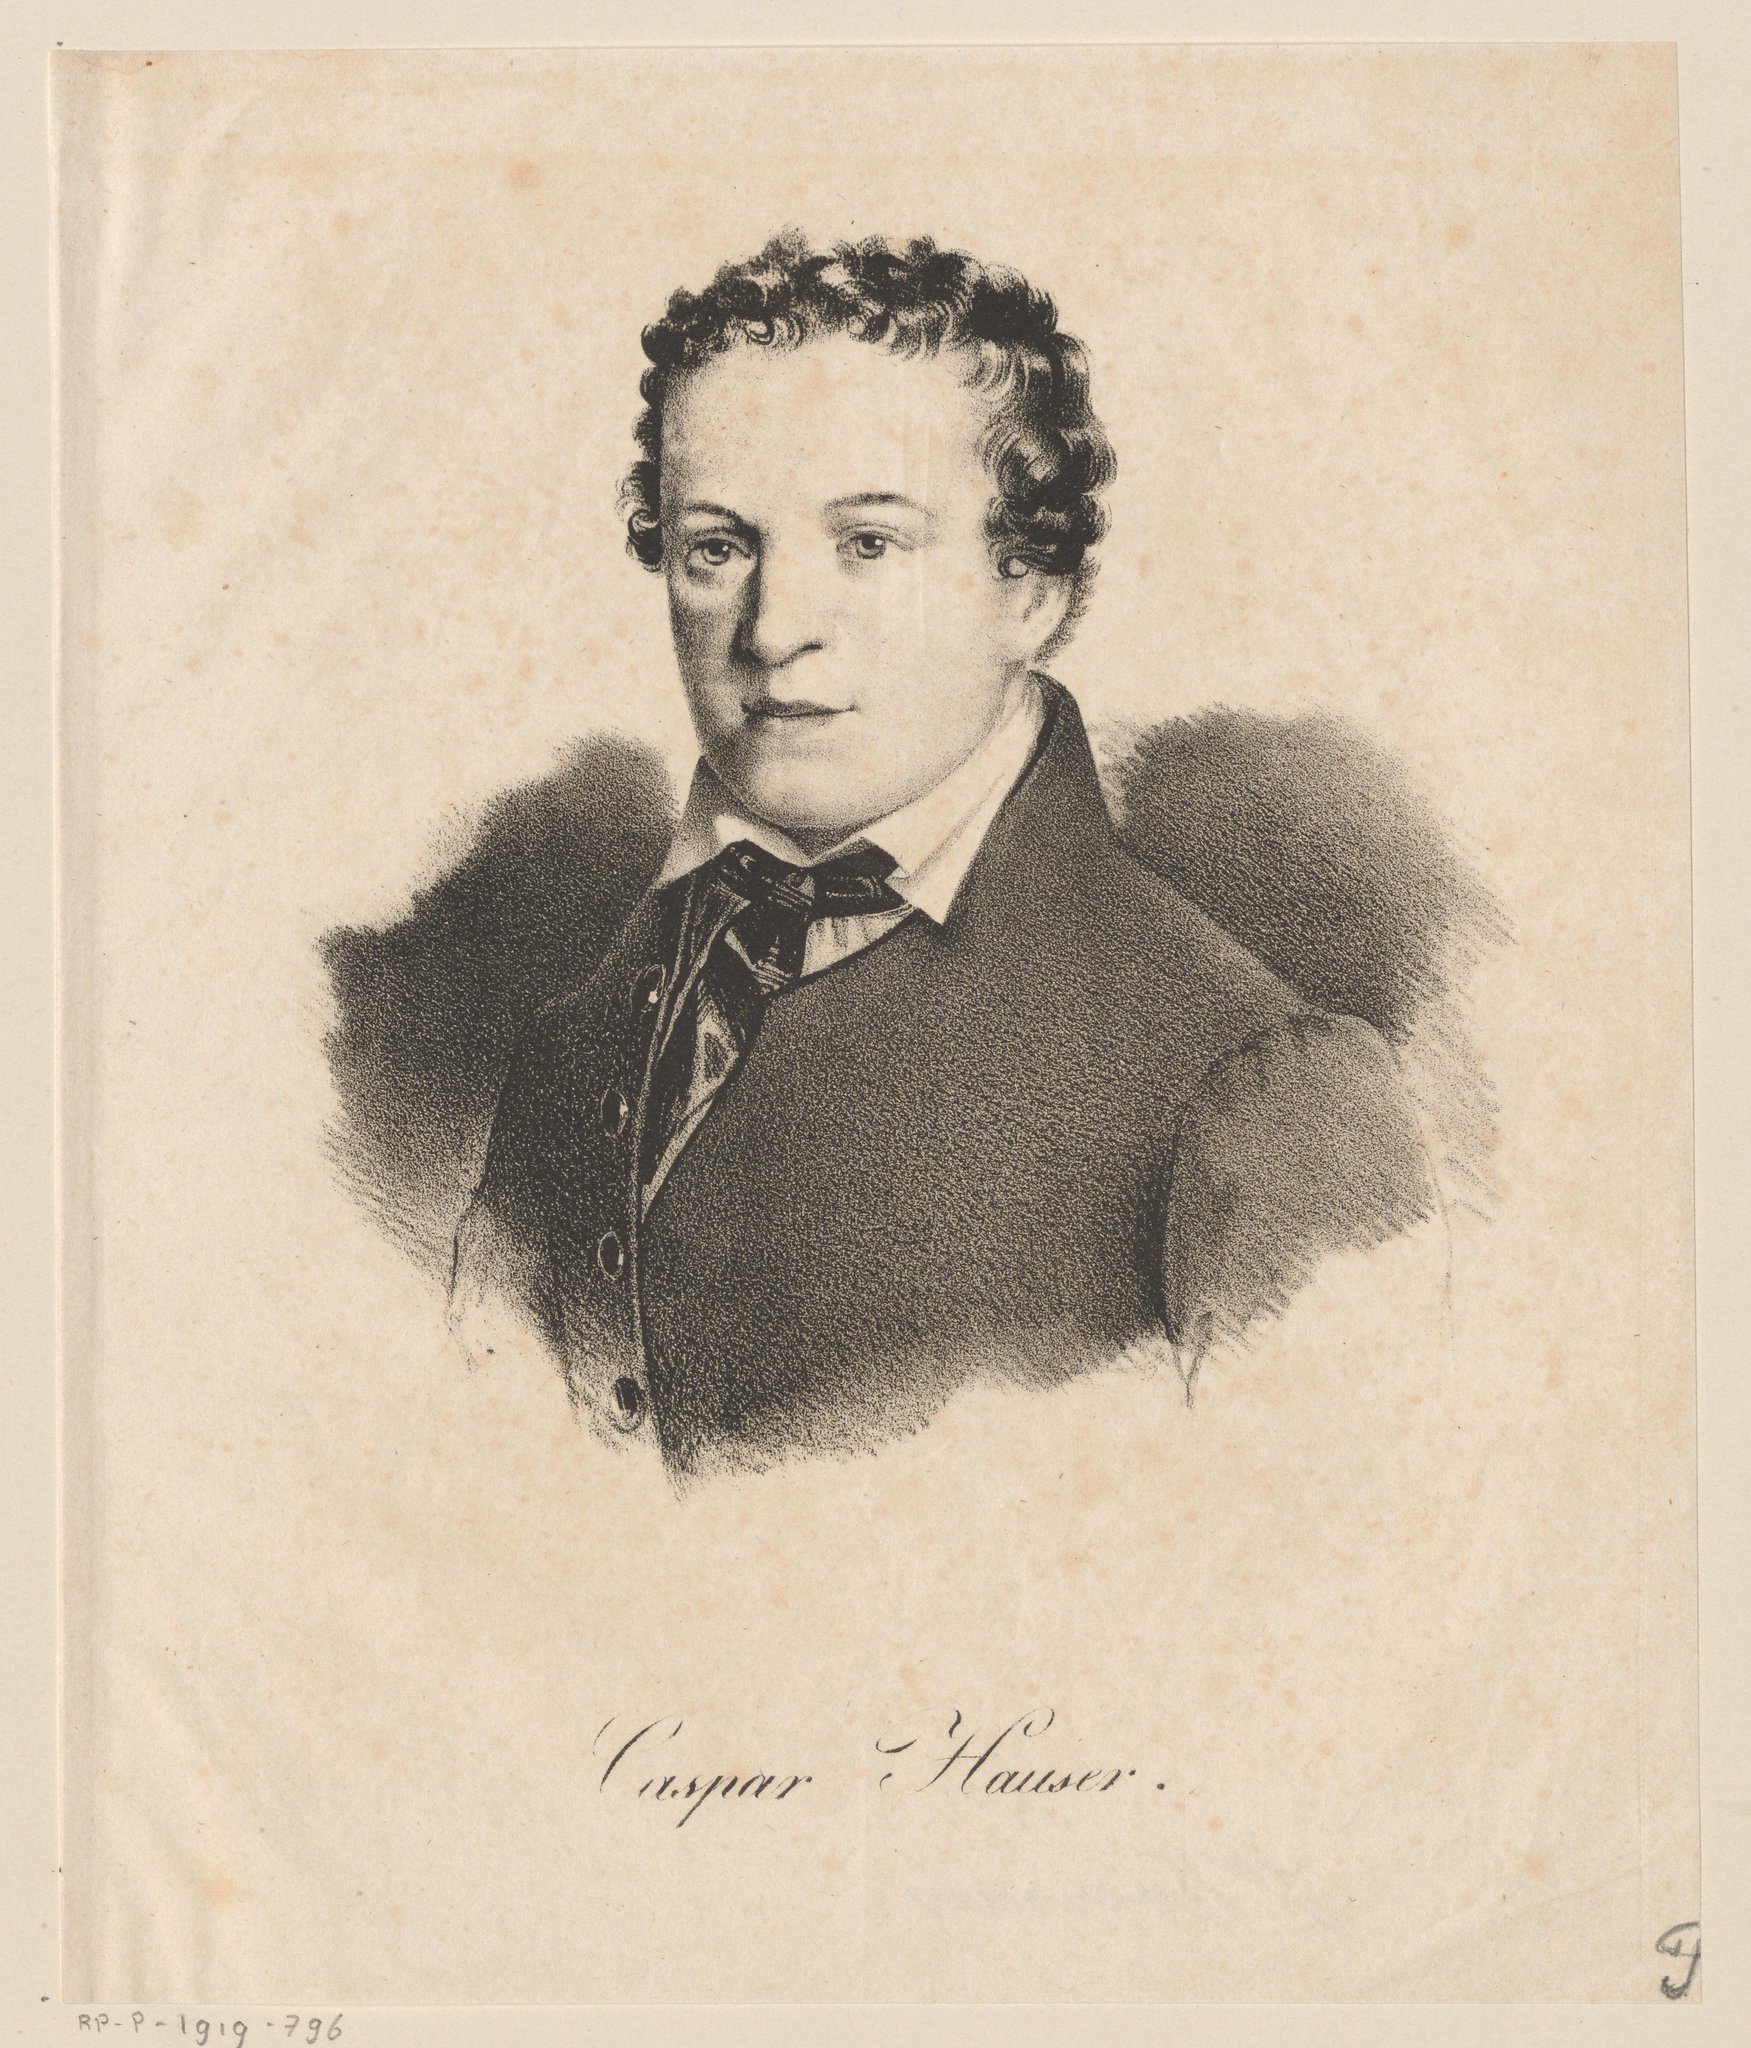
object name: print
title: Portret van Kaspar Hauser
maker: Anonymous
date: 1822-1849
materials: paper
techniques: lithograph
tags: historical persons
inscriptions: collector's mark: Lugt 2228